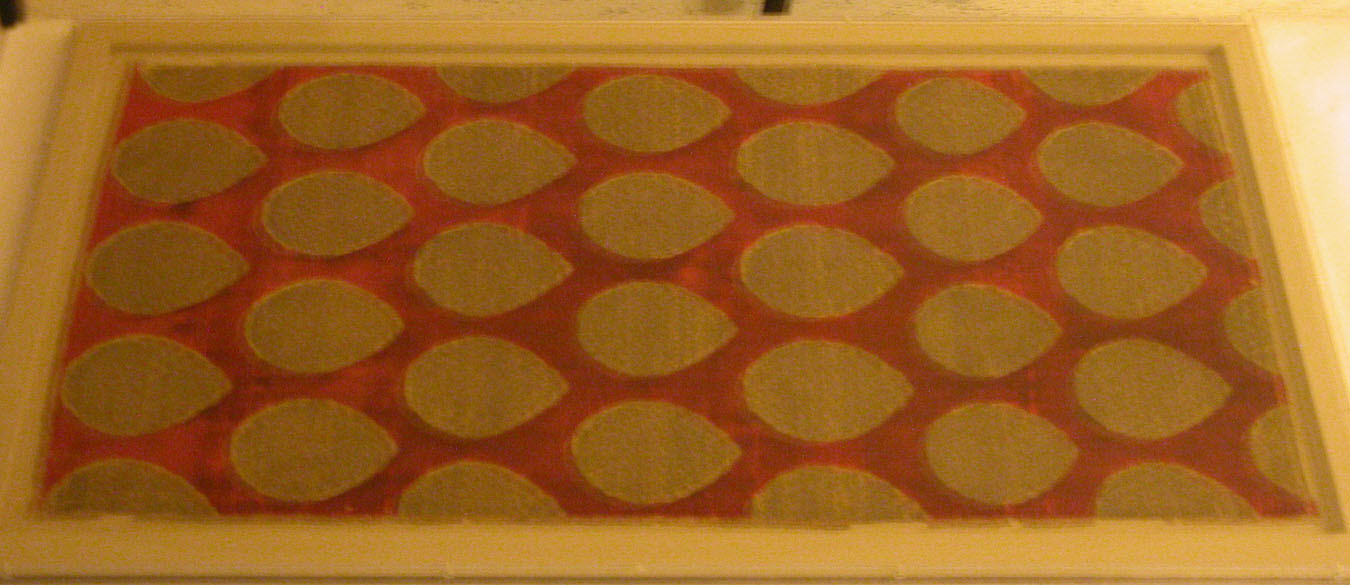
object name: textile fragment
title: Loom Width of Silk Velvet with 'Pinecone' Pattern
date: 1501-1600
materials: metal thread, silk, velvet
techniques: brocade, cutting, voiding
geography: turkey